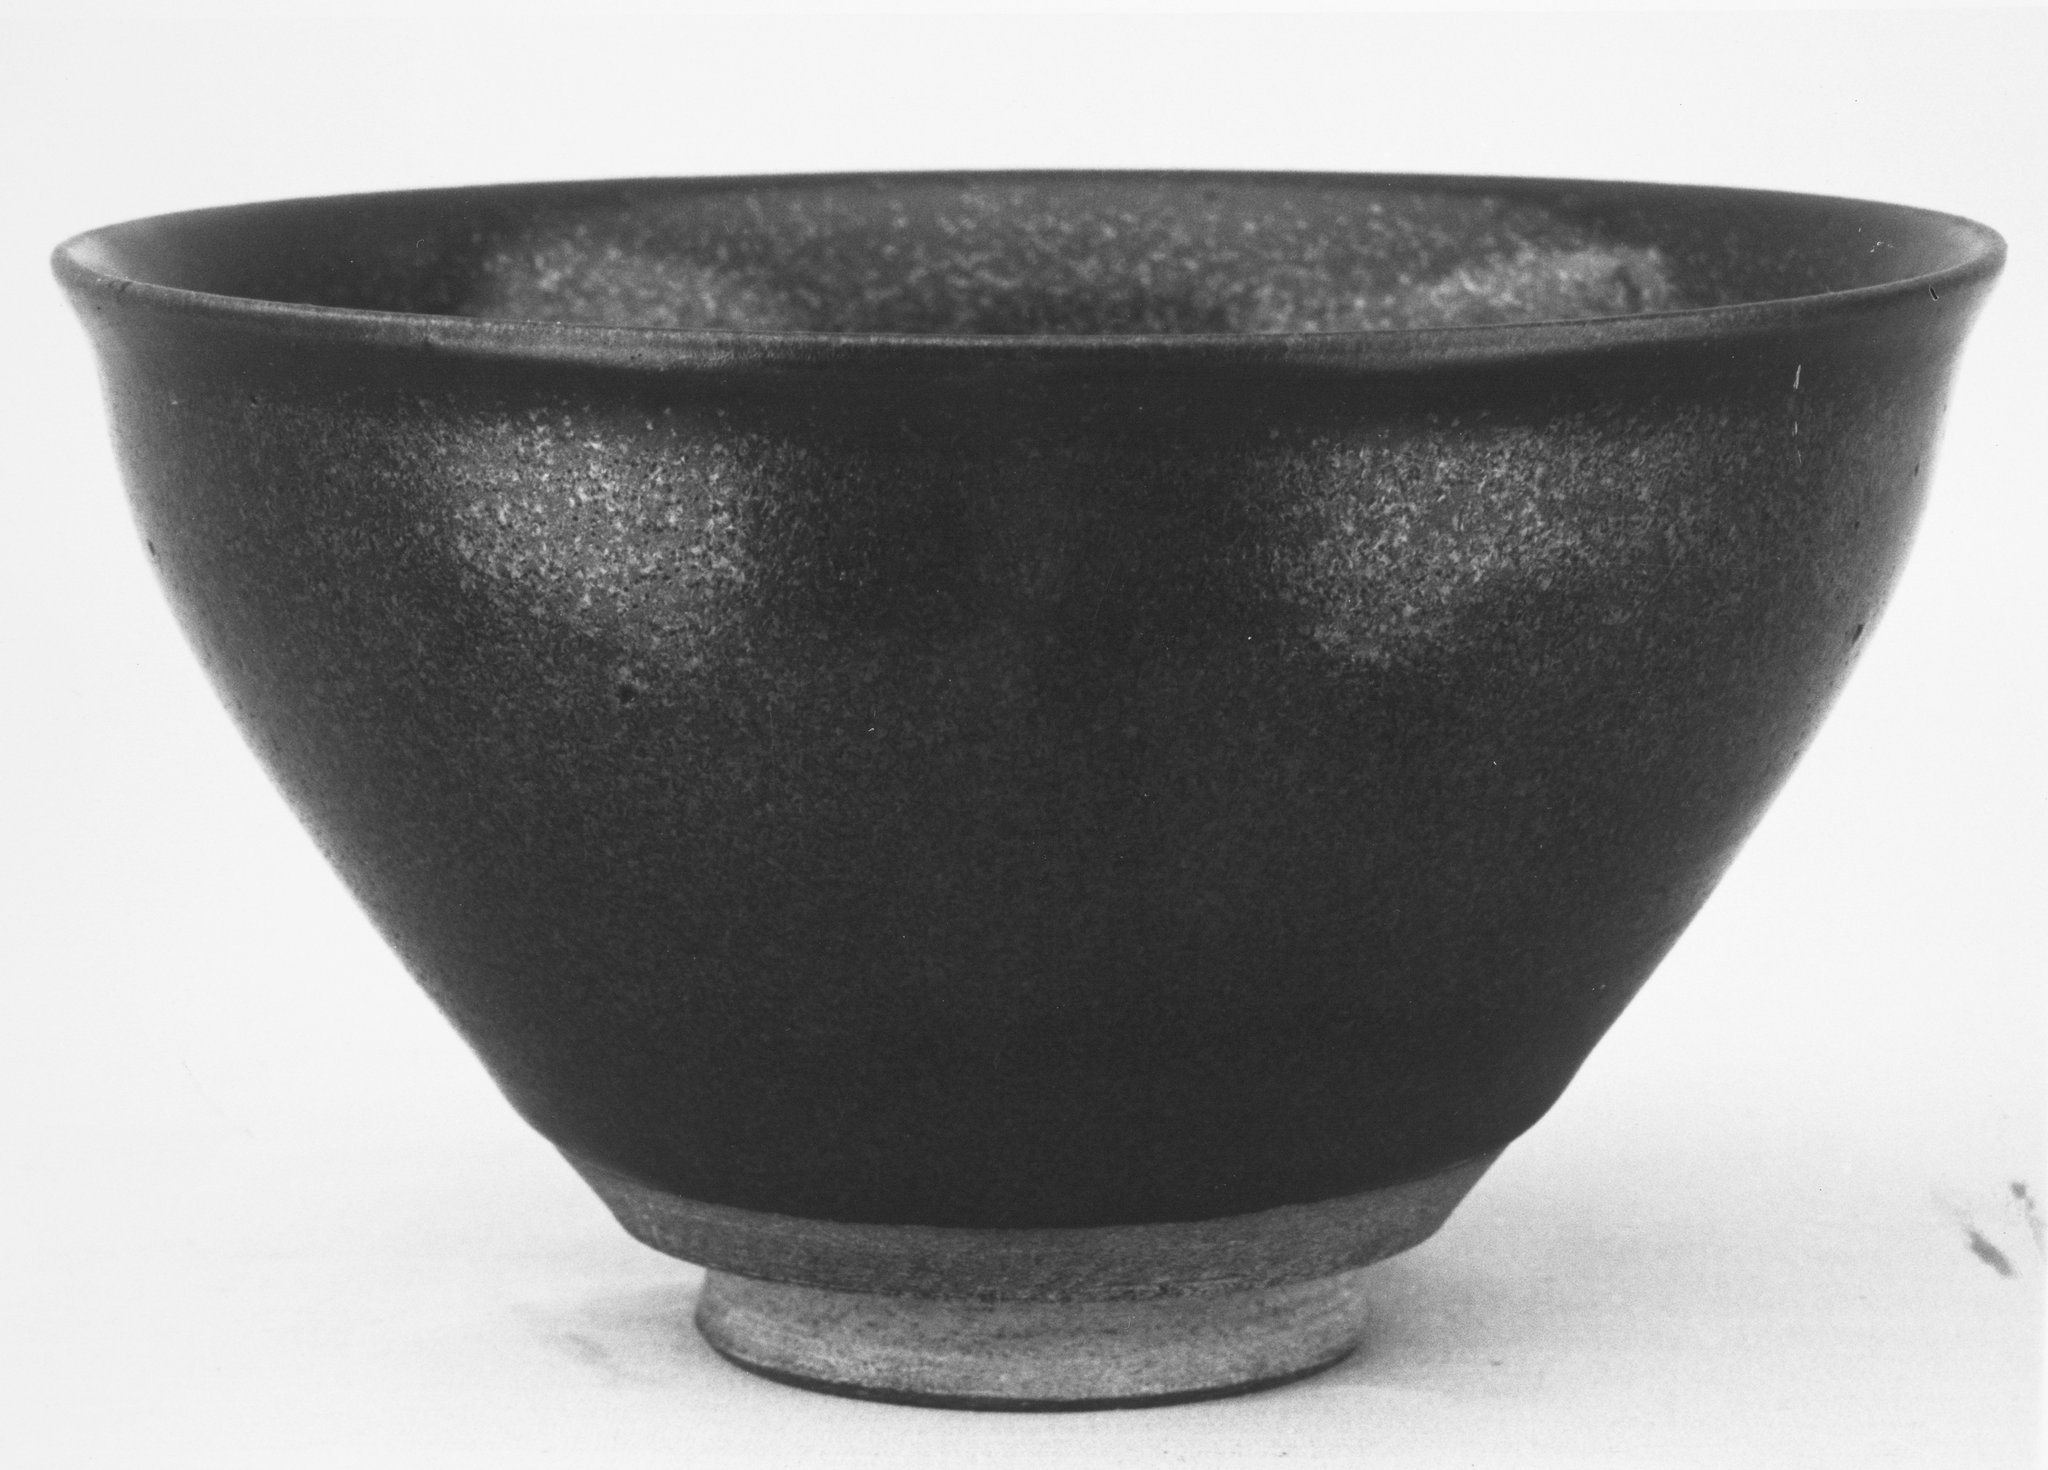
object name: teabowl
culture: japanese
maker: eiraku wazen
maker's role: artist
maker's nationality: japanese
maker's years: 1823-1896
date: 1850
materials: clay, glaze